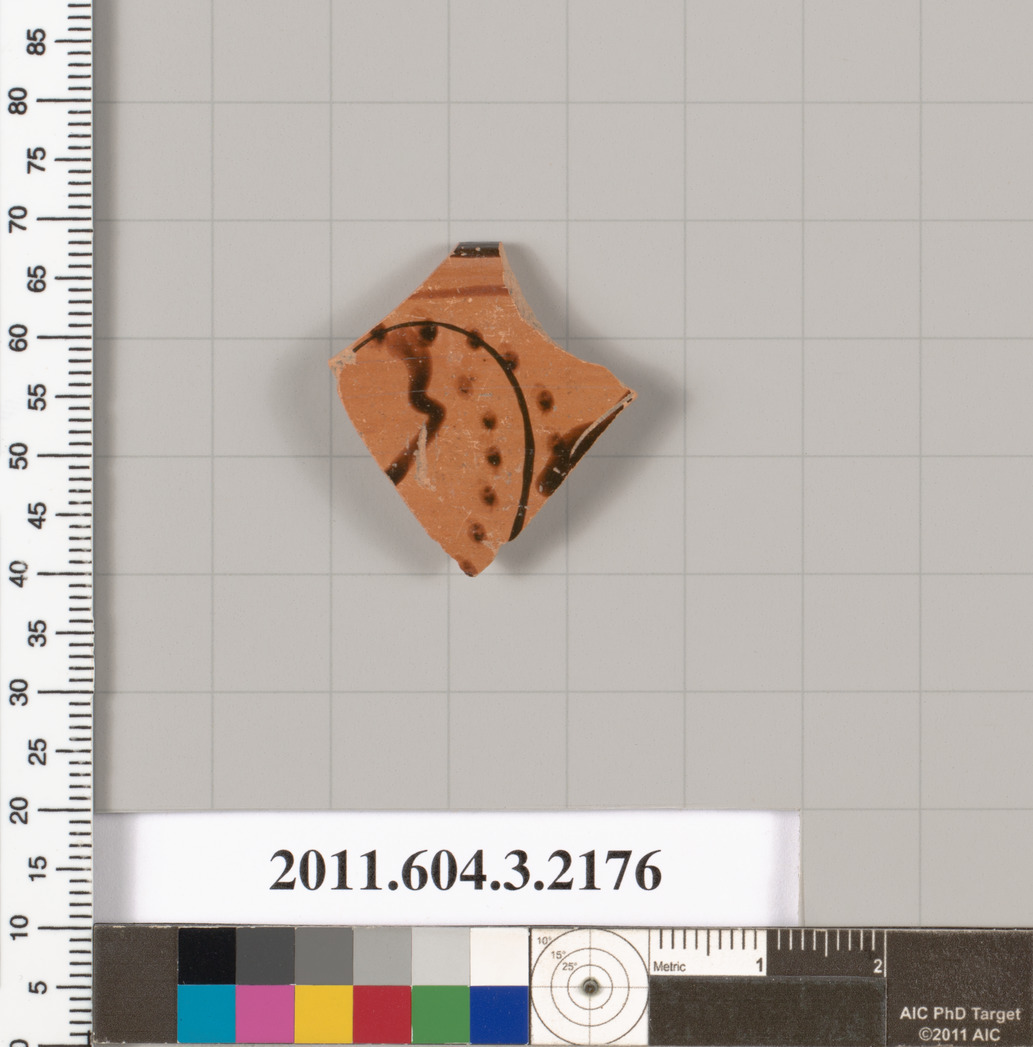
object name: kylix fragment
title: Terracotta rim fragment of a kylix (drinking cup)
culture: greek, attic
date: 534-501 BCE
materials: terracotta